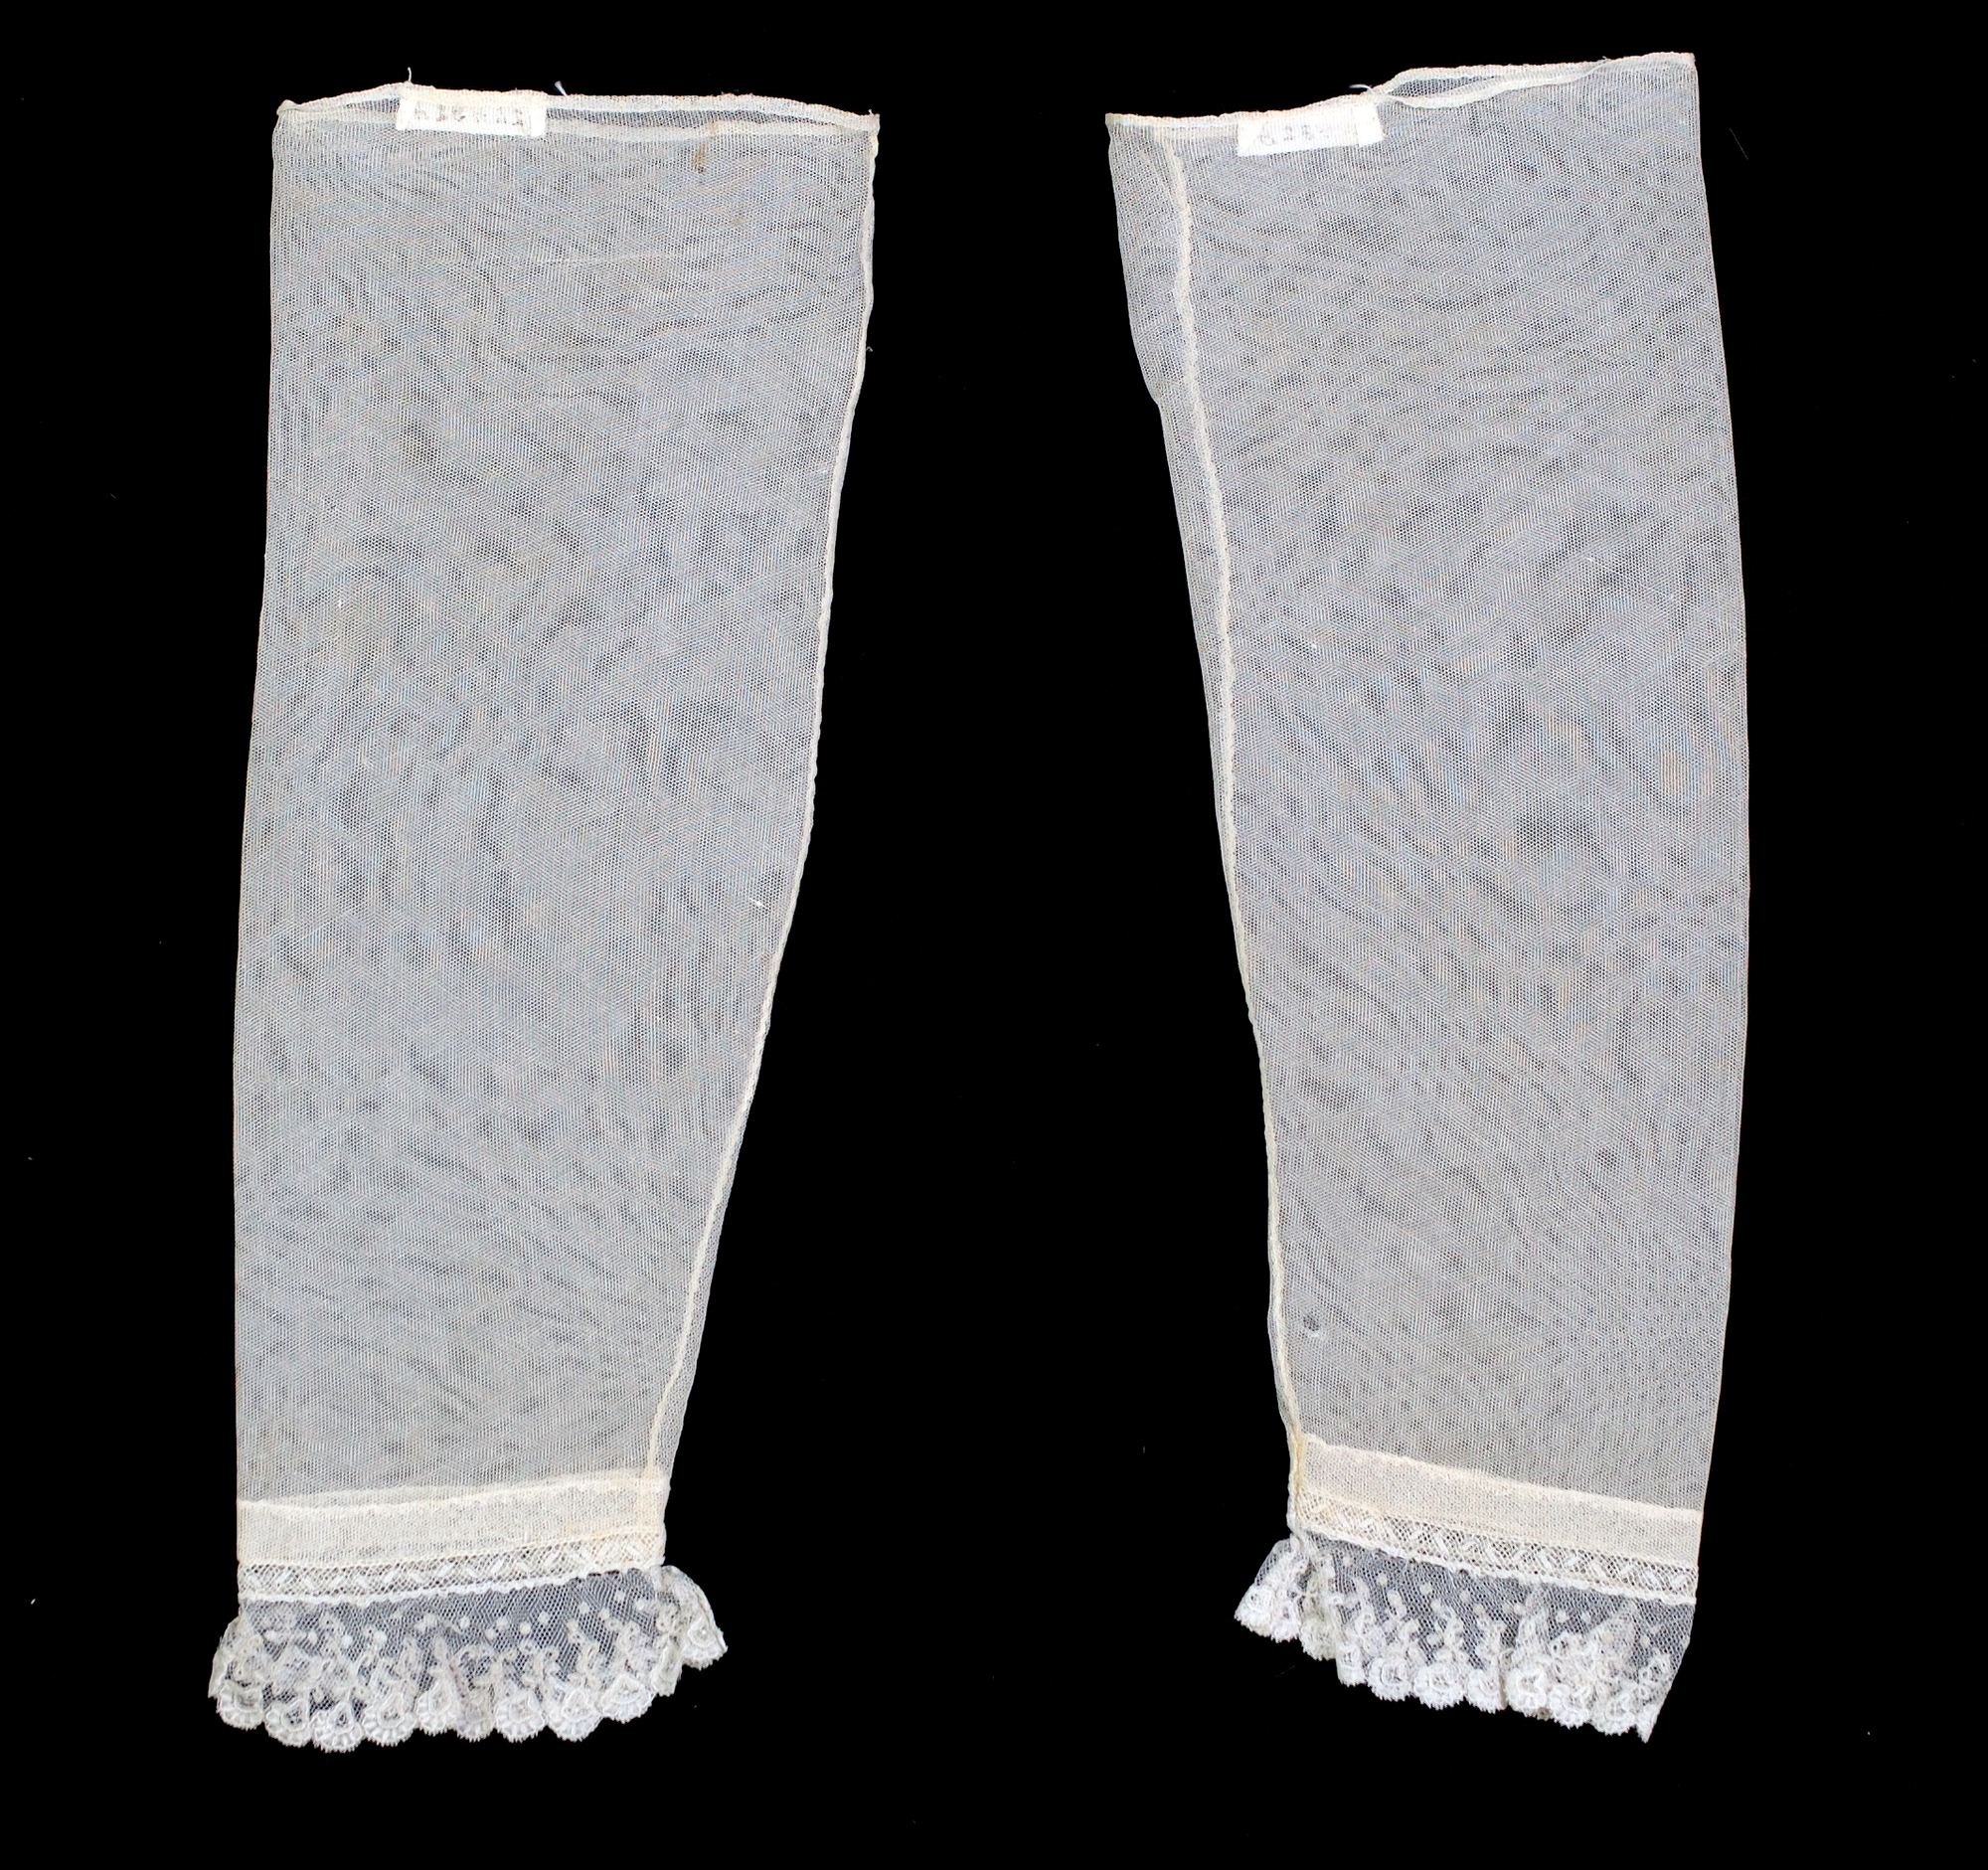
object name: undersleeves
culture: american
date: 1801-1833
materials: silk